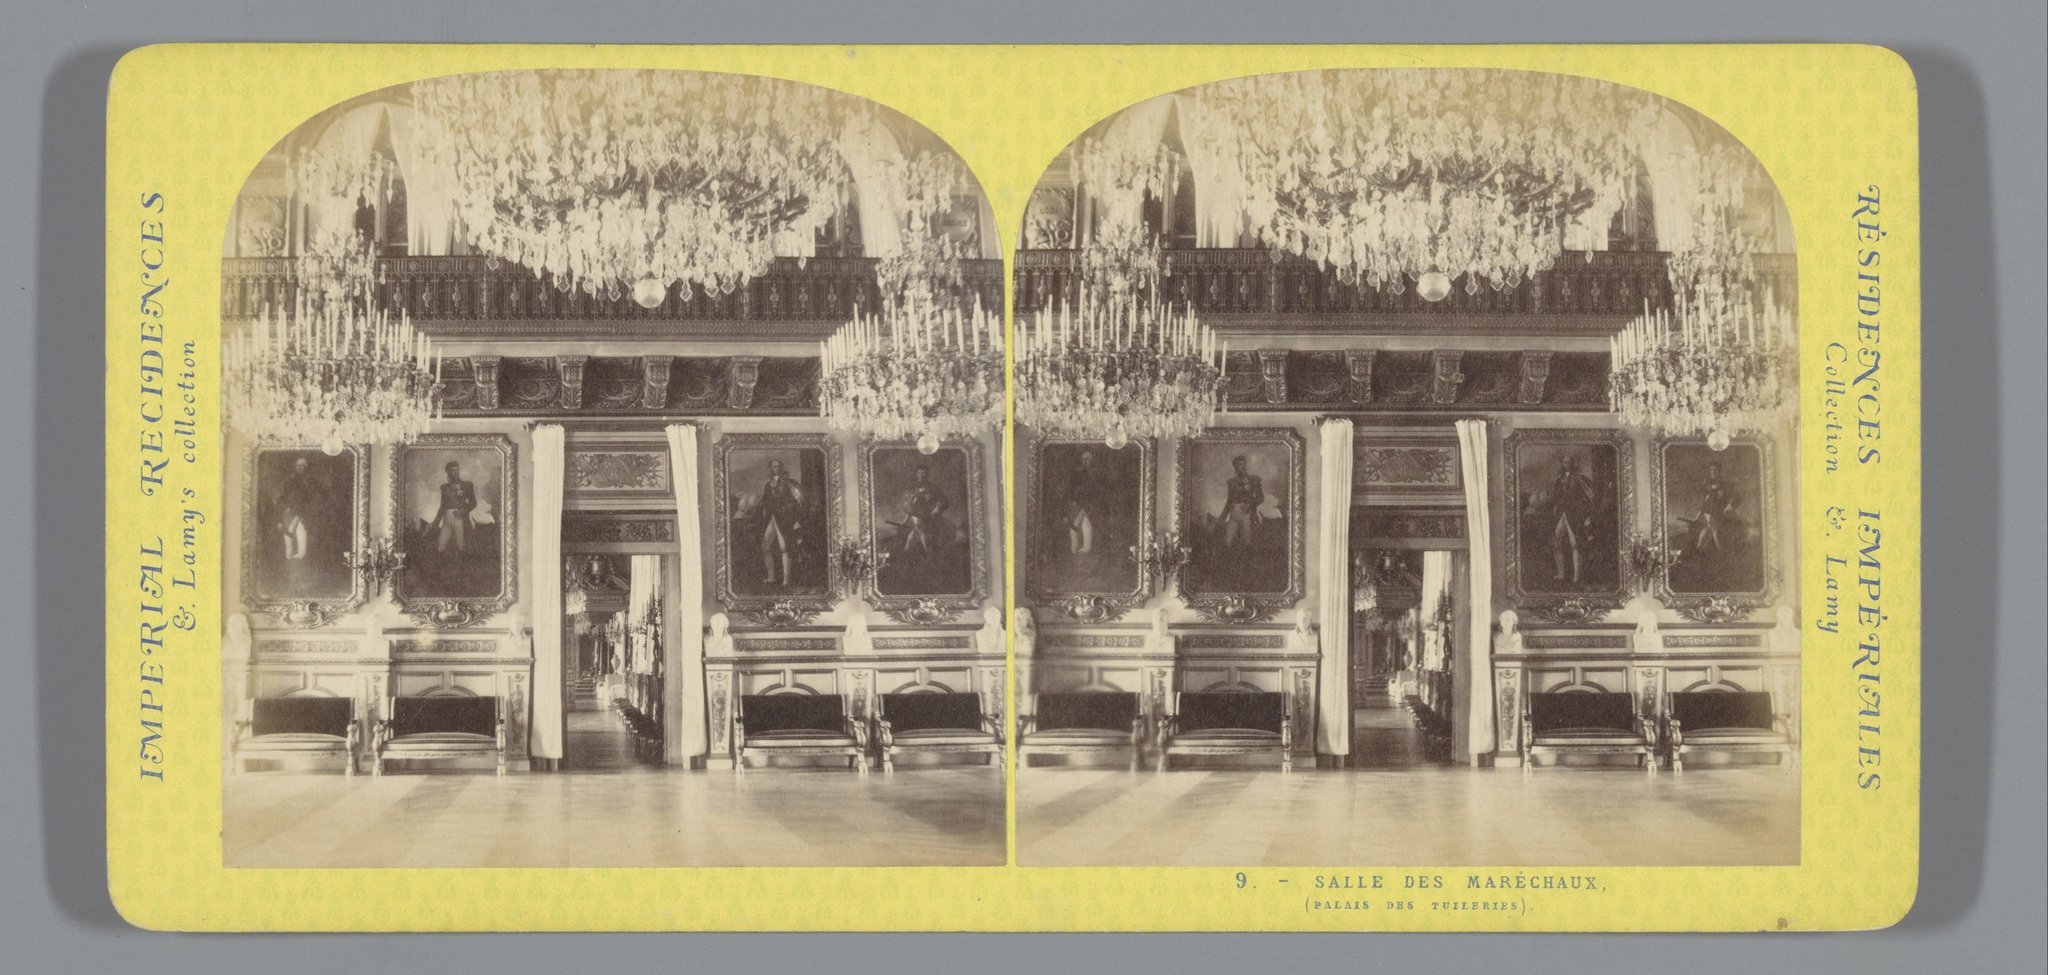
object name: stereograph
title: Interieur van de Salle des Marechaux in het Palais des Tuileries te Parijs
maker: ernest eléonor pierre lamy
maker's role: publisher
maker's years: 1828-1900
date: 1860-1871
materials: cardboard, photographic support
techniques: albumen print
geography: tuileries palace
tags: drawing-room, 'salon', palace, interior ~ representation of a building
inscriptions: number: ‘9.’, inscription: ‘E. Lamy's collection’